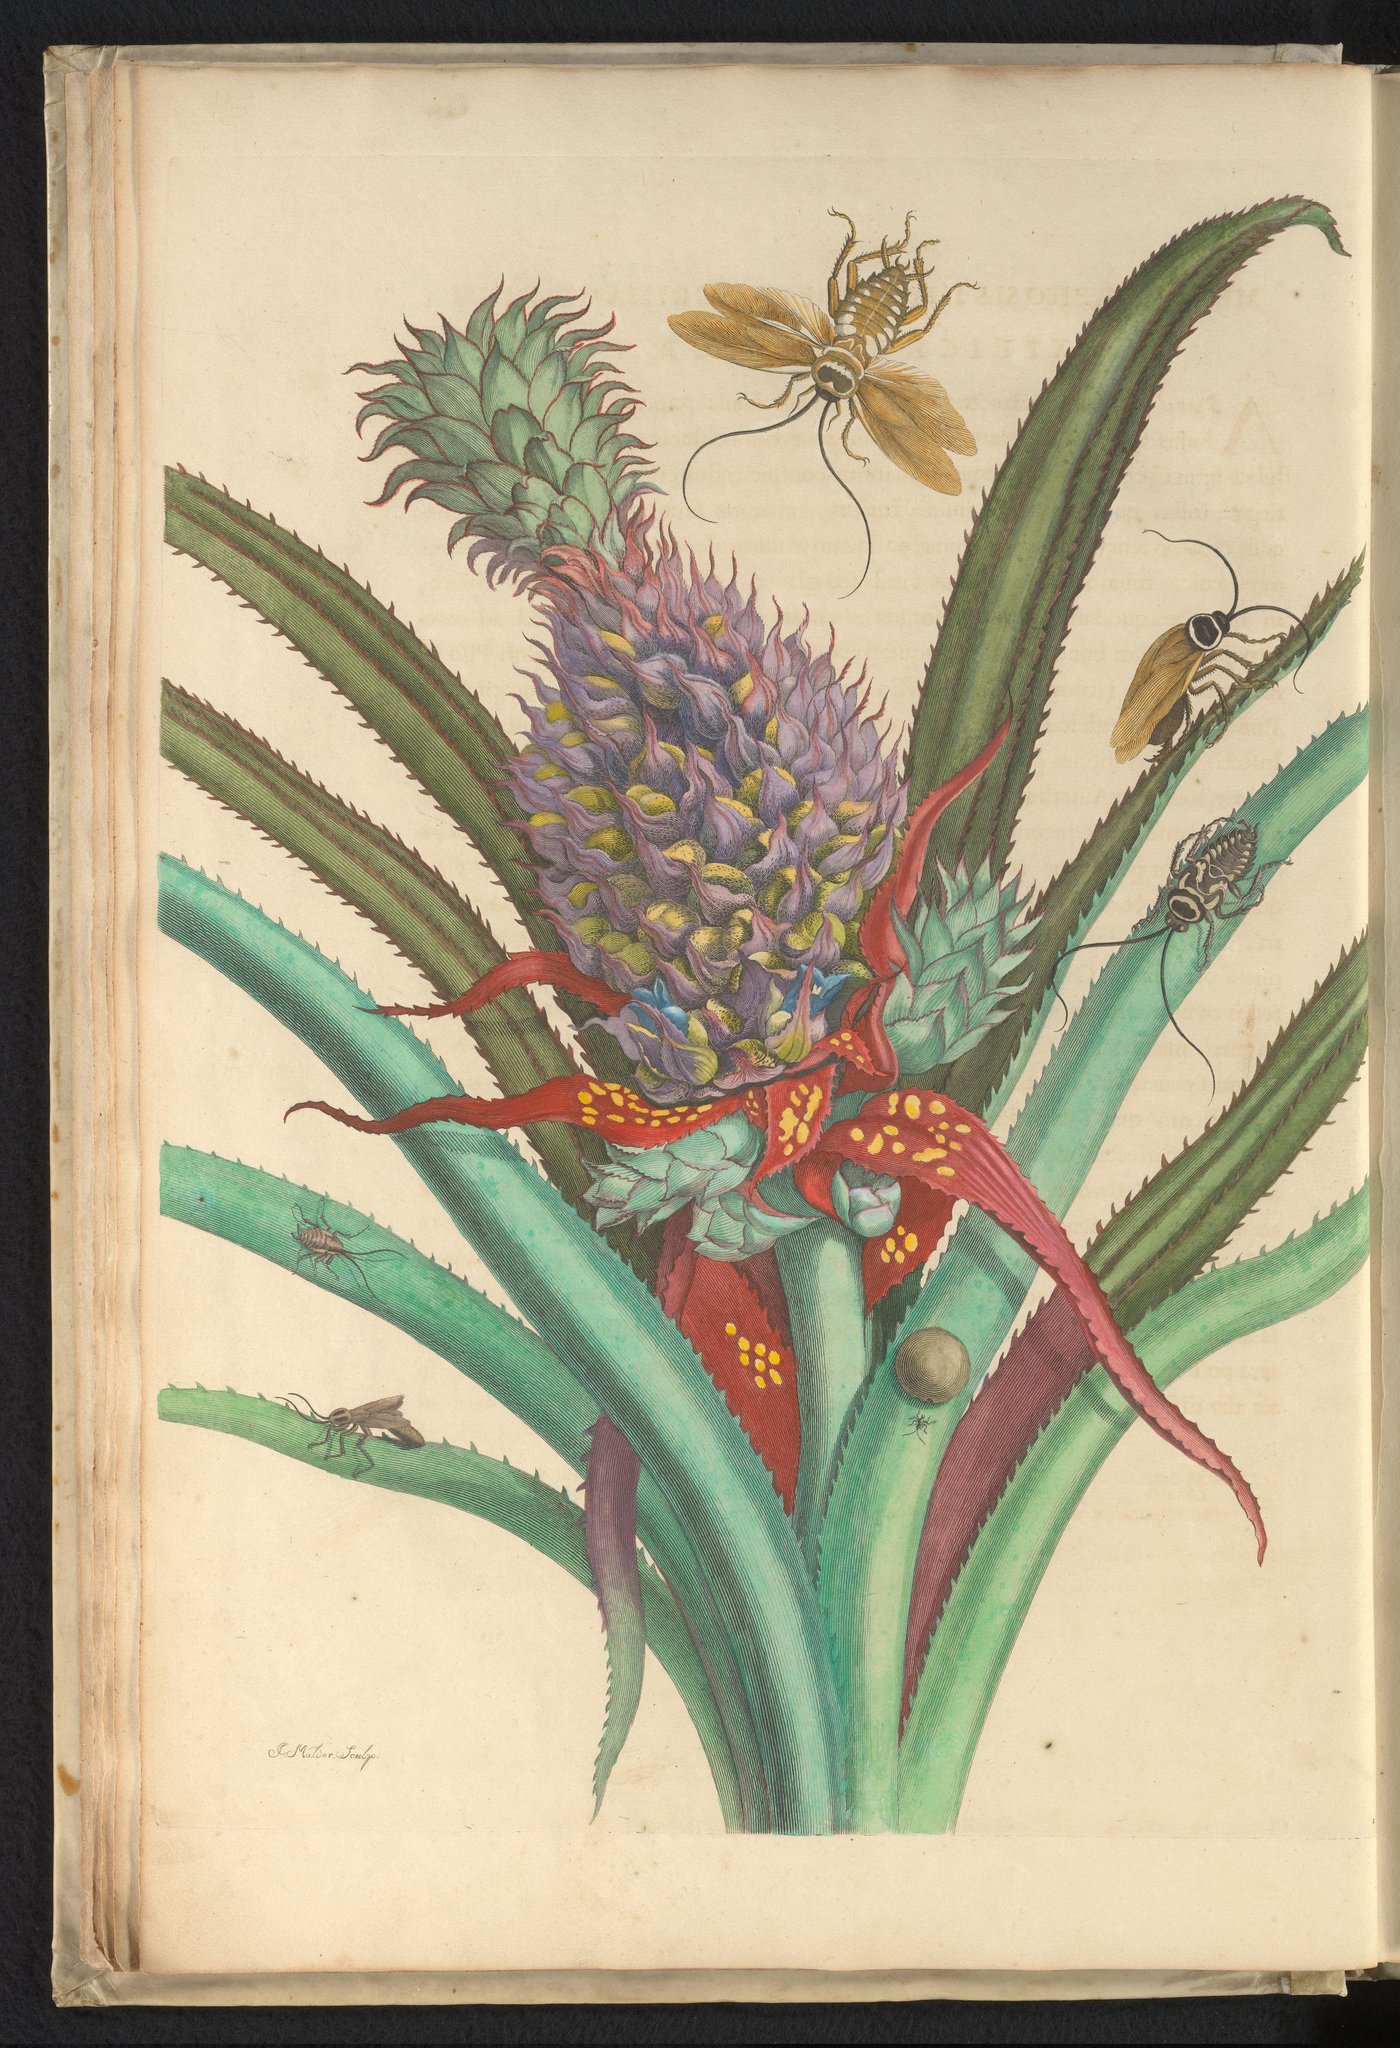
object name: print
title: Ananasplant (Ananas comosus) met kakkerlakken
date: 1705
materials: paper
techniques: etching, hand coloring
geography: amsterdam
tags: fruits: pineapple, insects: cockroach, suriname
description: Rechtsonder genummerd: 1. Prent maakt deel uit van een boek.